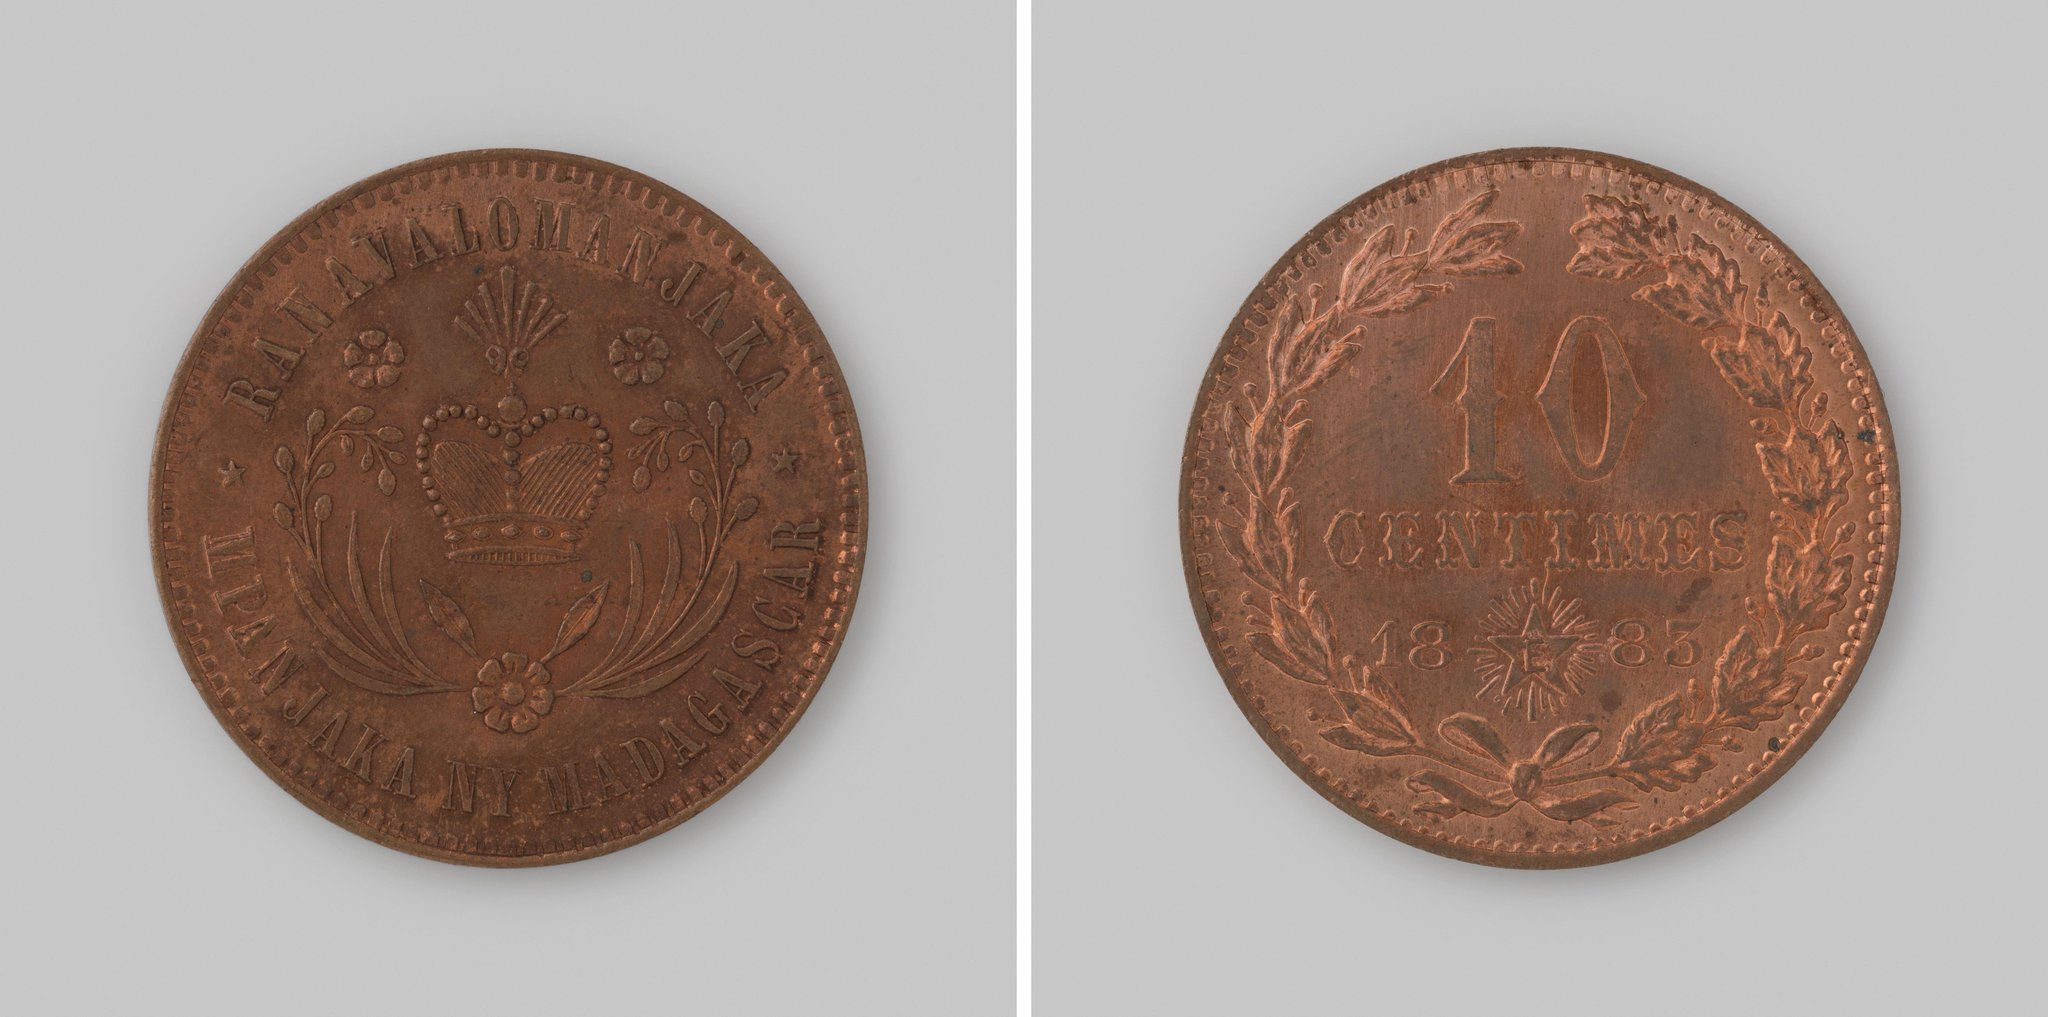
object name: coin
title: 10 centimes van Madagascar, 1883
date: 1883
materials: nickel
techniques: striking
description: Nikkelen particuliere munt, in opdracht van munthandelaren geslagen. Voorzijde: ?. Keerzijde: ?